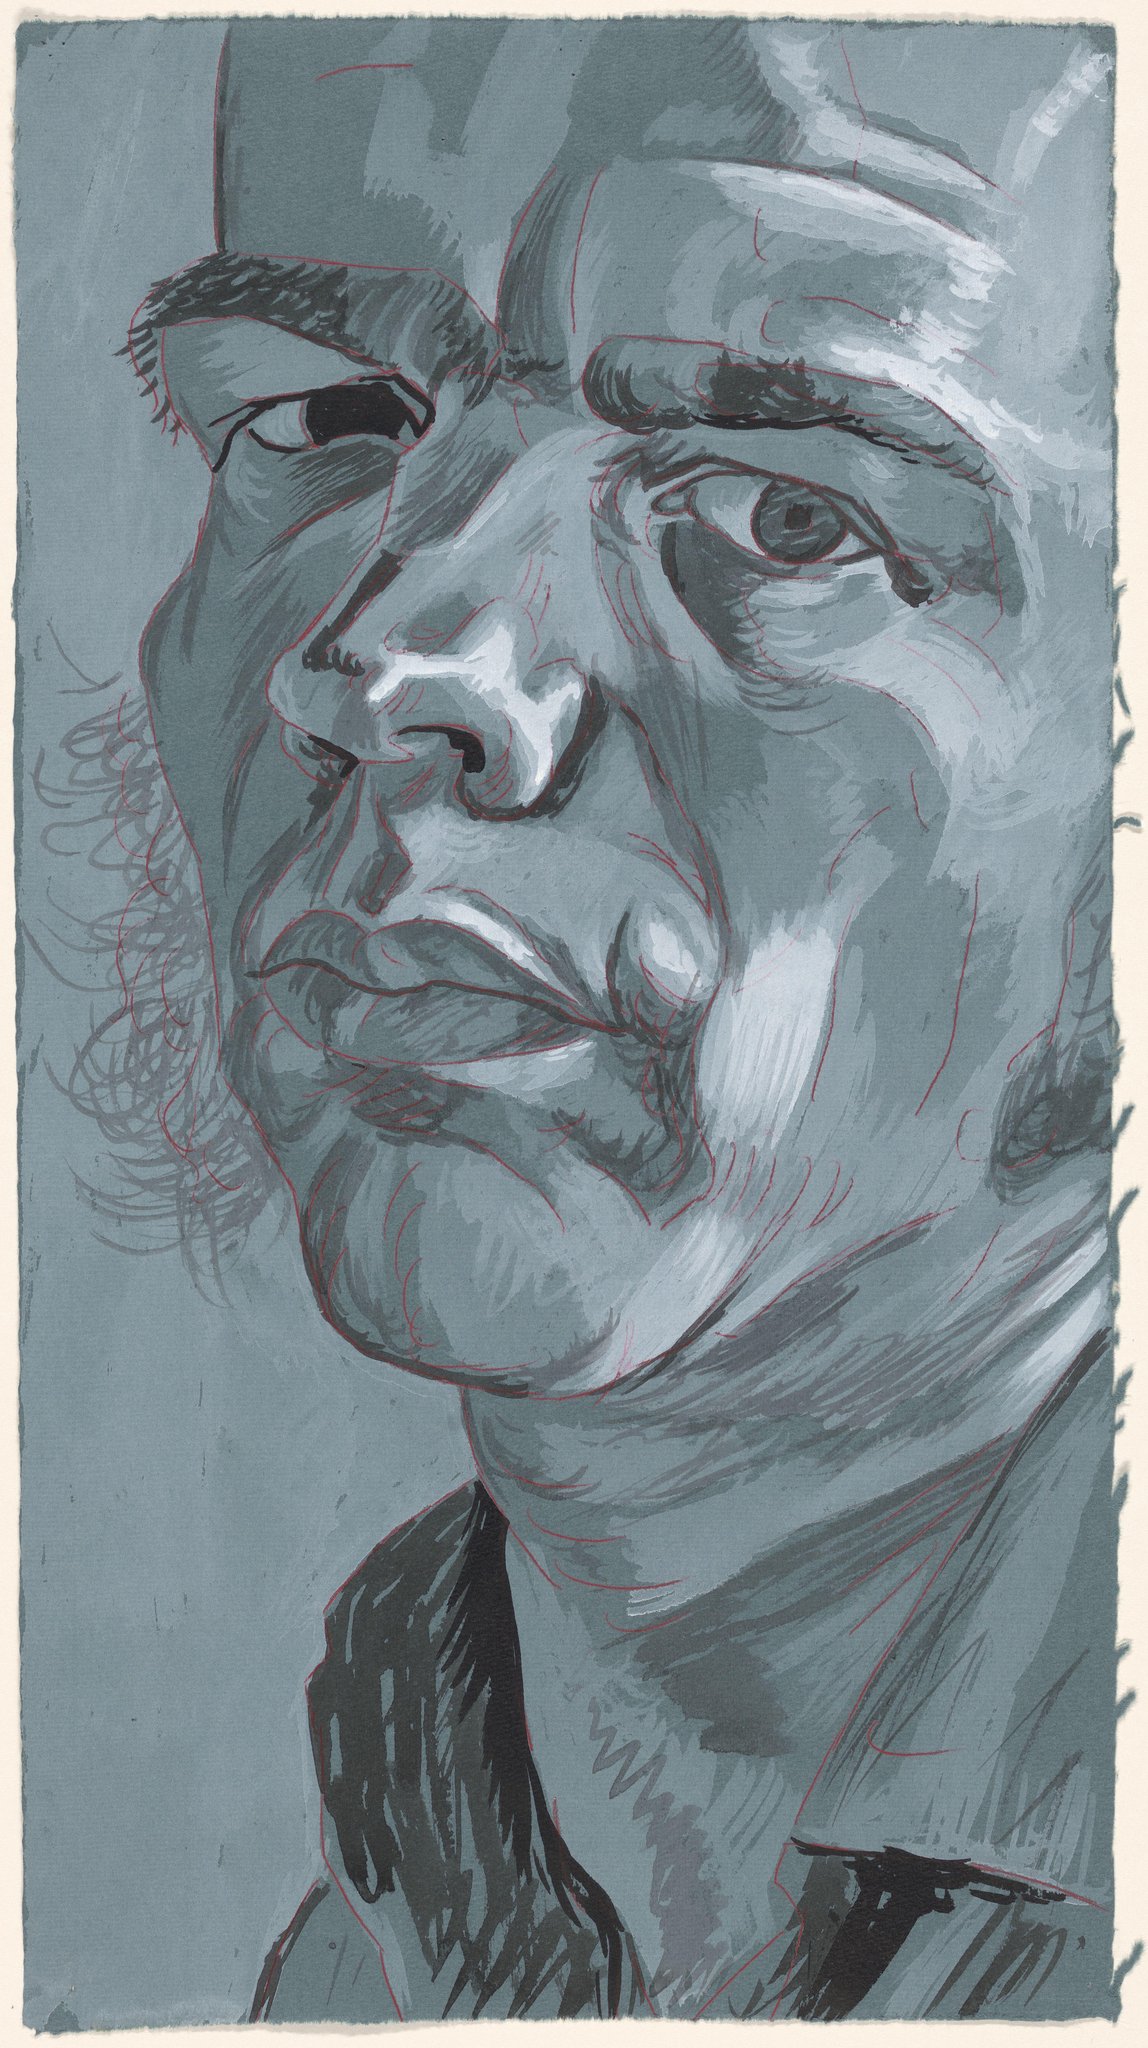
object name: drawing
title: Zelfportret 1990 nr. 45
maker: philip akkerman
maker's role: draughtsman, painter, sculptor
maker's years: 1957-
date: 1990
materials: ink, paper, watercolor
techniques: brush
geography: netherlands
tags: painter, draughtsman, sculptor, philip akkerman, historical persons, portrait, self-portrait of painter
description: ¾ En face weergegeven, ingezoomd zelfportret met krullende bakkebaarden en overhemd.